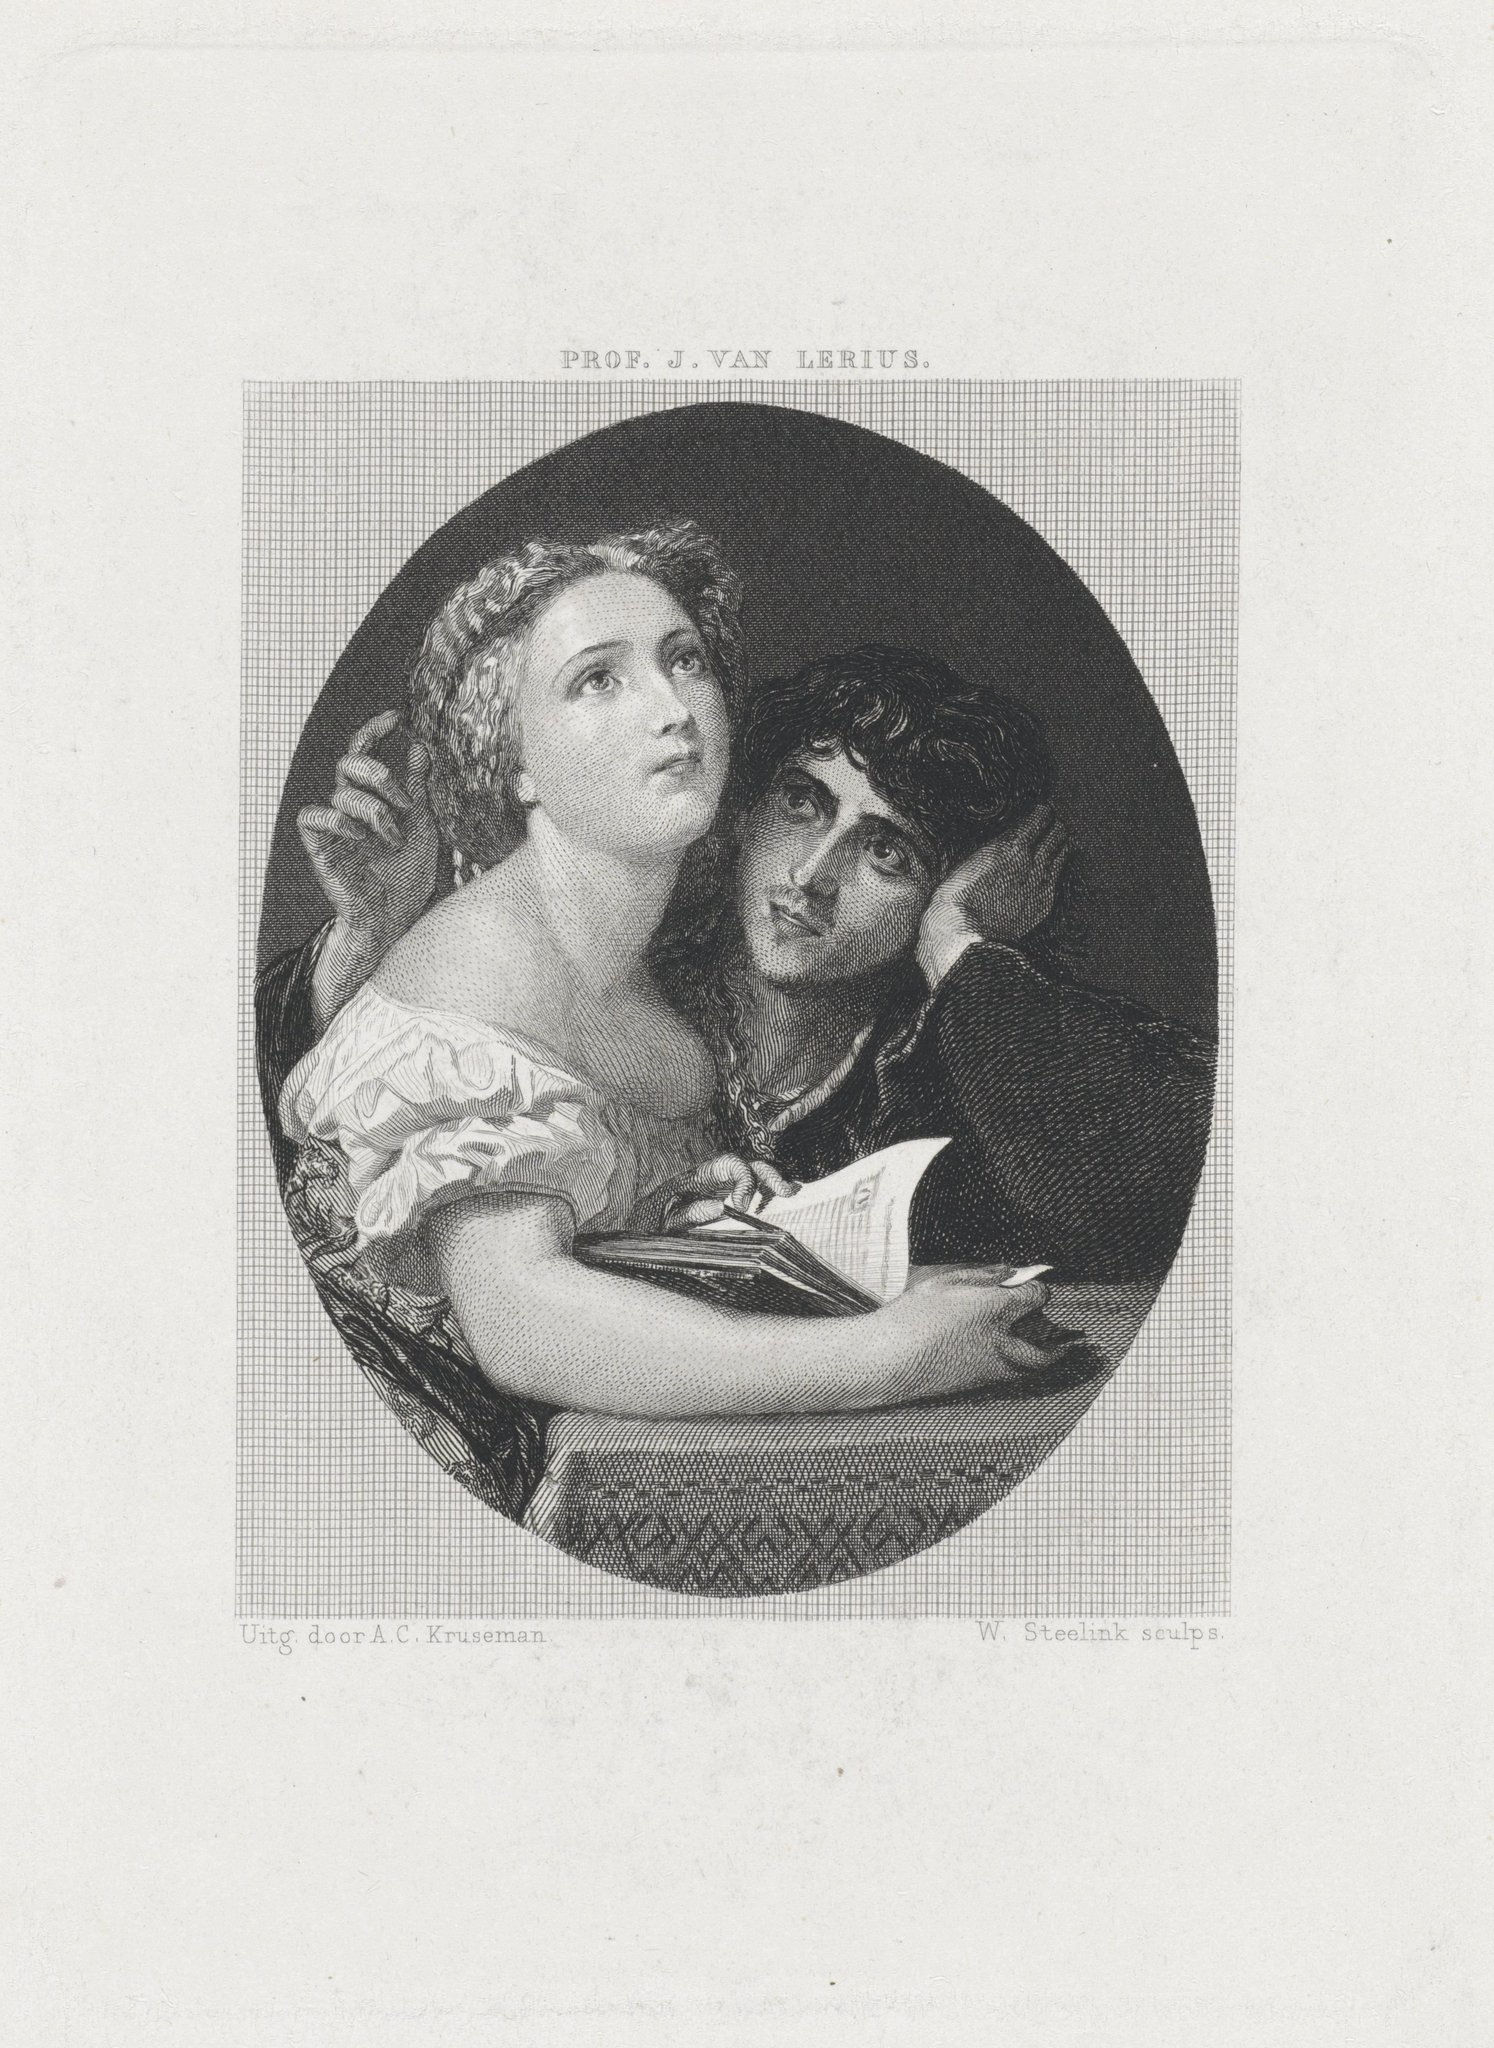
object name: book illustration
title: Paar aan een tafel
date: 1865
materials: paper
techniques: etching, engraving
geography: amsterdam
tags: reading, couple of lovers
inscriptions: collector's mark: Lugt 2228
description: Een paar zit samen aan tafel. De vrouw houdt een opengeslagen boek in de handen en kijkt omhoog.